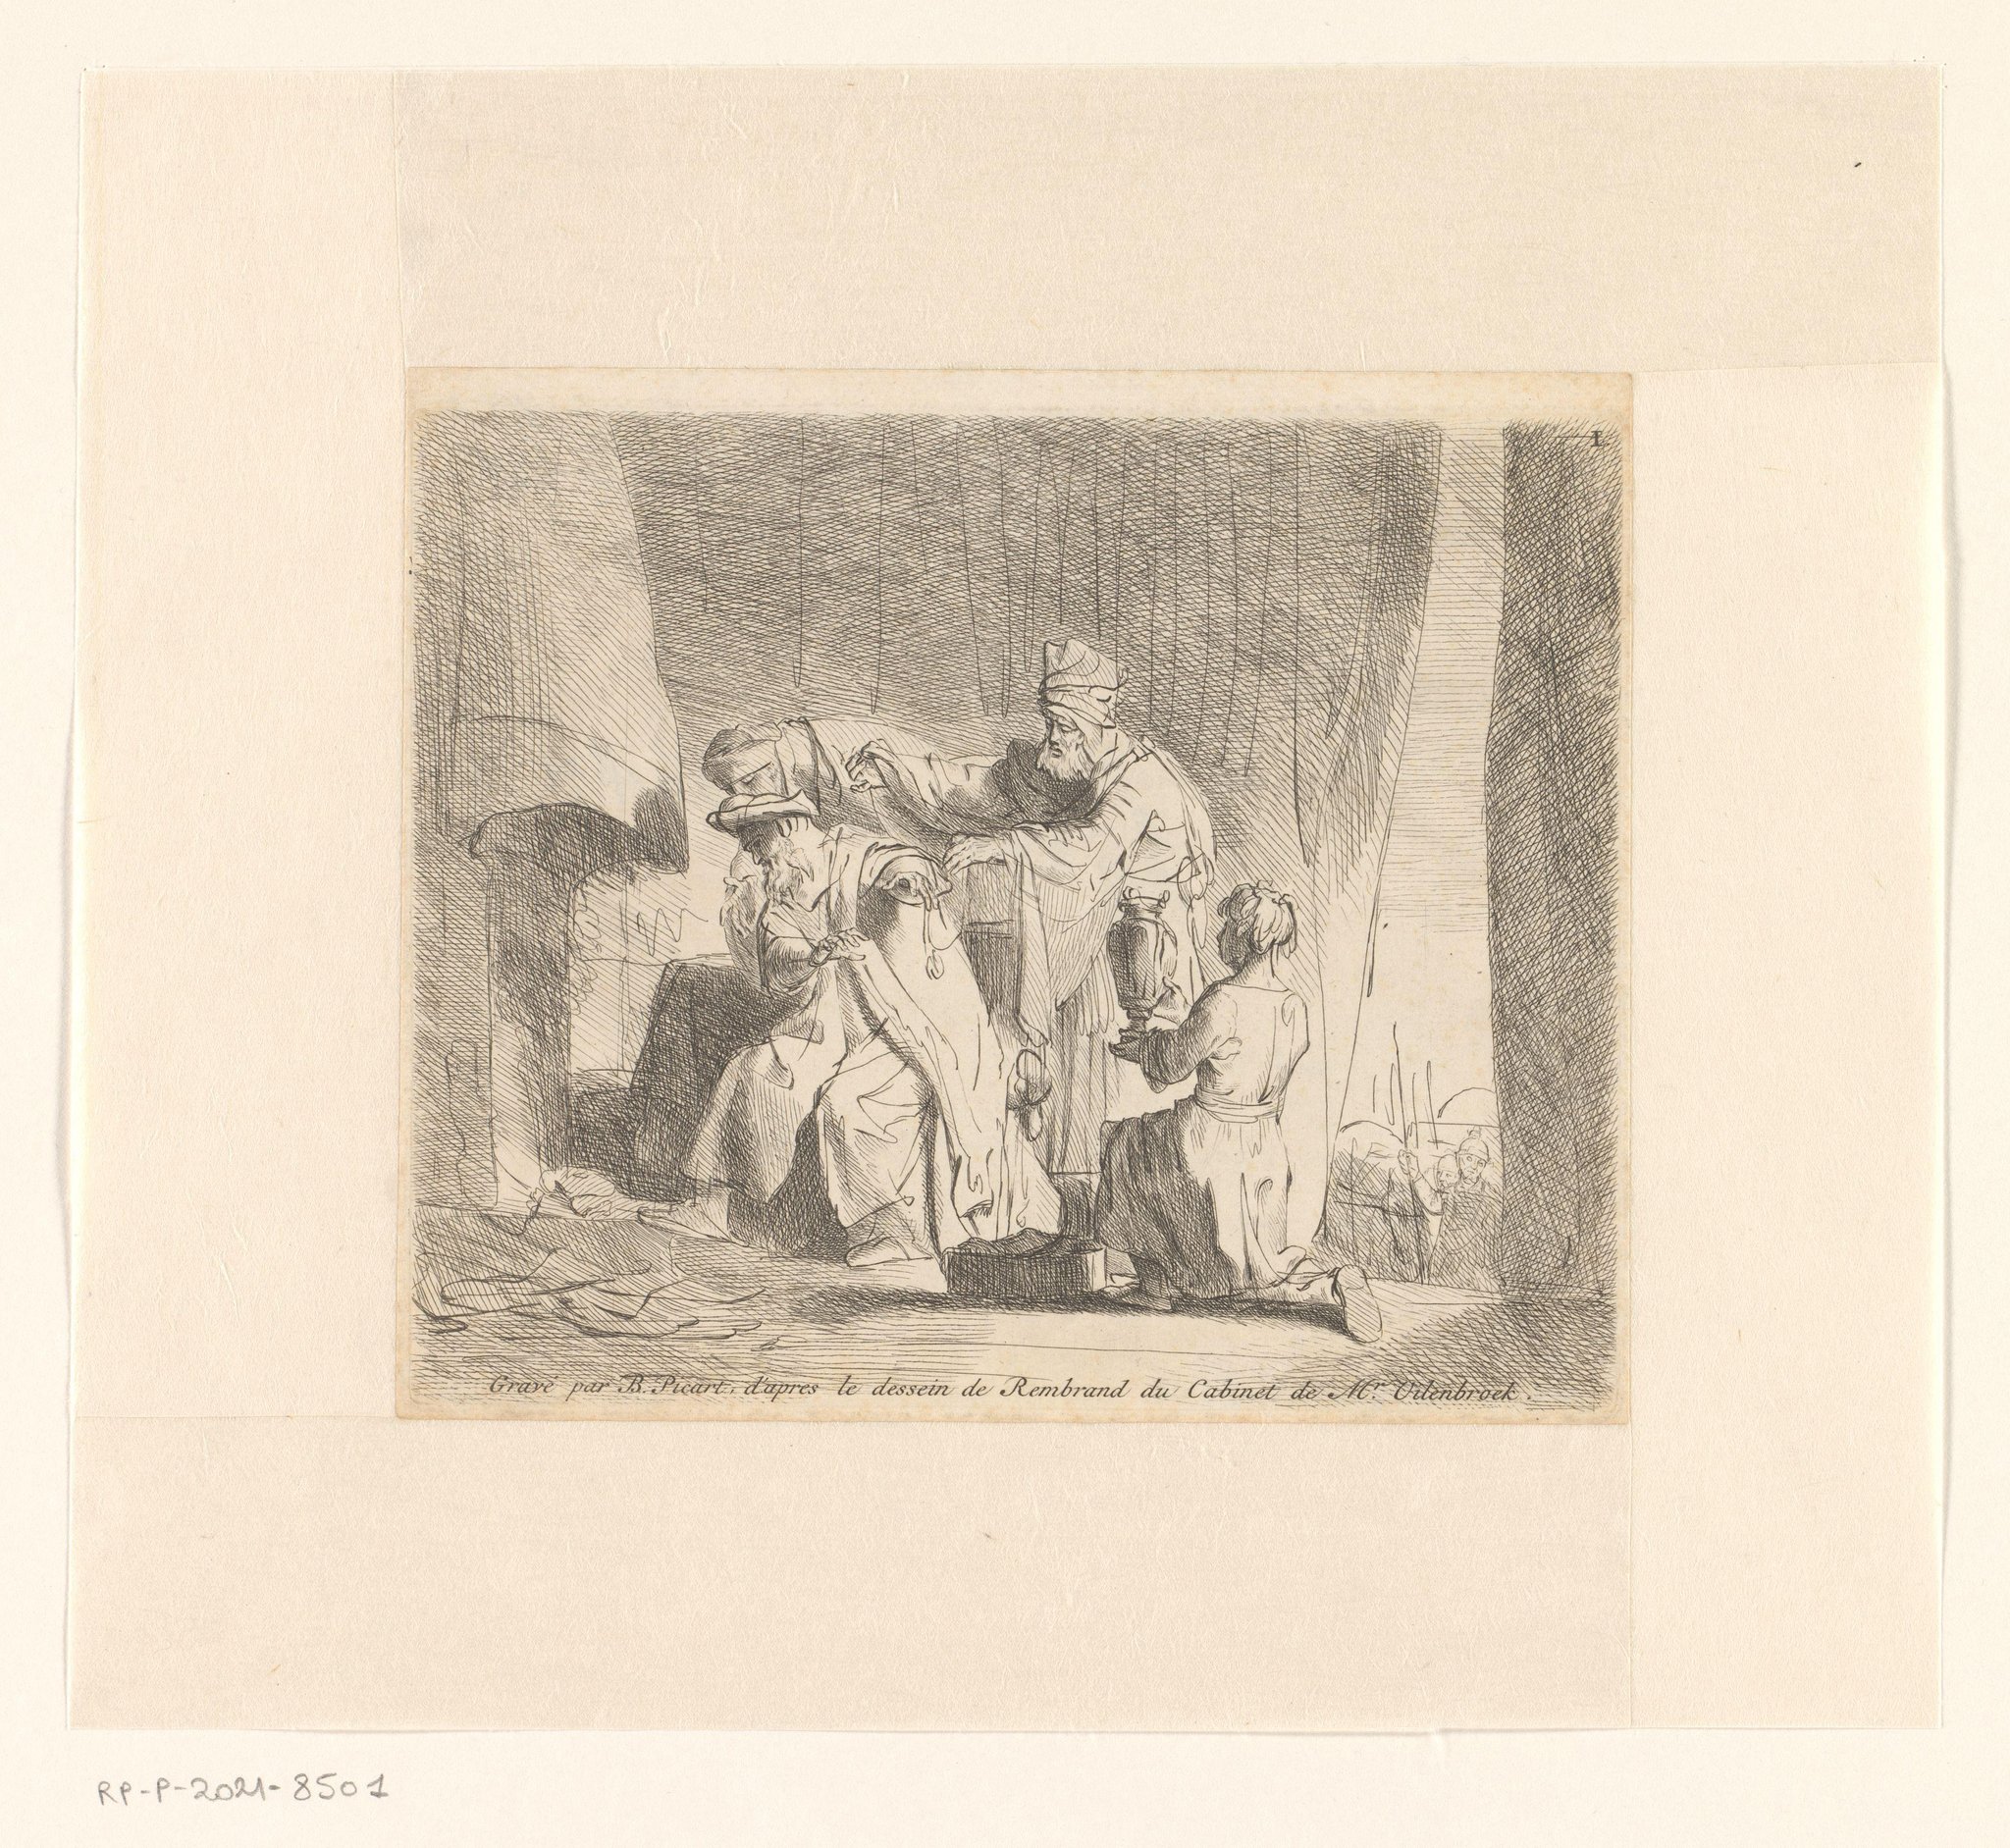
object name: print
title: Manius Curius Dentatus weigert geschenken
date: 1734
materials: paper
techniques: etching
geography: amsterdam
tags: historical persons, male persons from classical history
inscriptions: number: ‘III c’, inscription: ‘Manius Curius refusant les presents/ planche des "Impostures Innocentes"’, inscription: ‘F.L +/ 1707’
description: Prent waarschijnlijk uit: Impostures innocentes, ou recueil d'estampes d'apres divers peintres (...) par Bernard Picart (...) avec son elogue historique et le catalogue de ses ouvrages. Amsterdam: weduwe Bernard Picart, 1734.